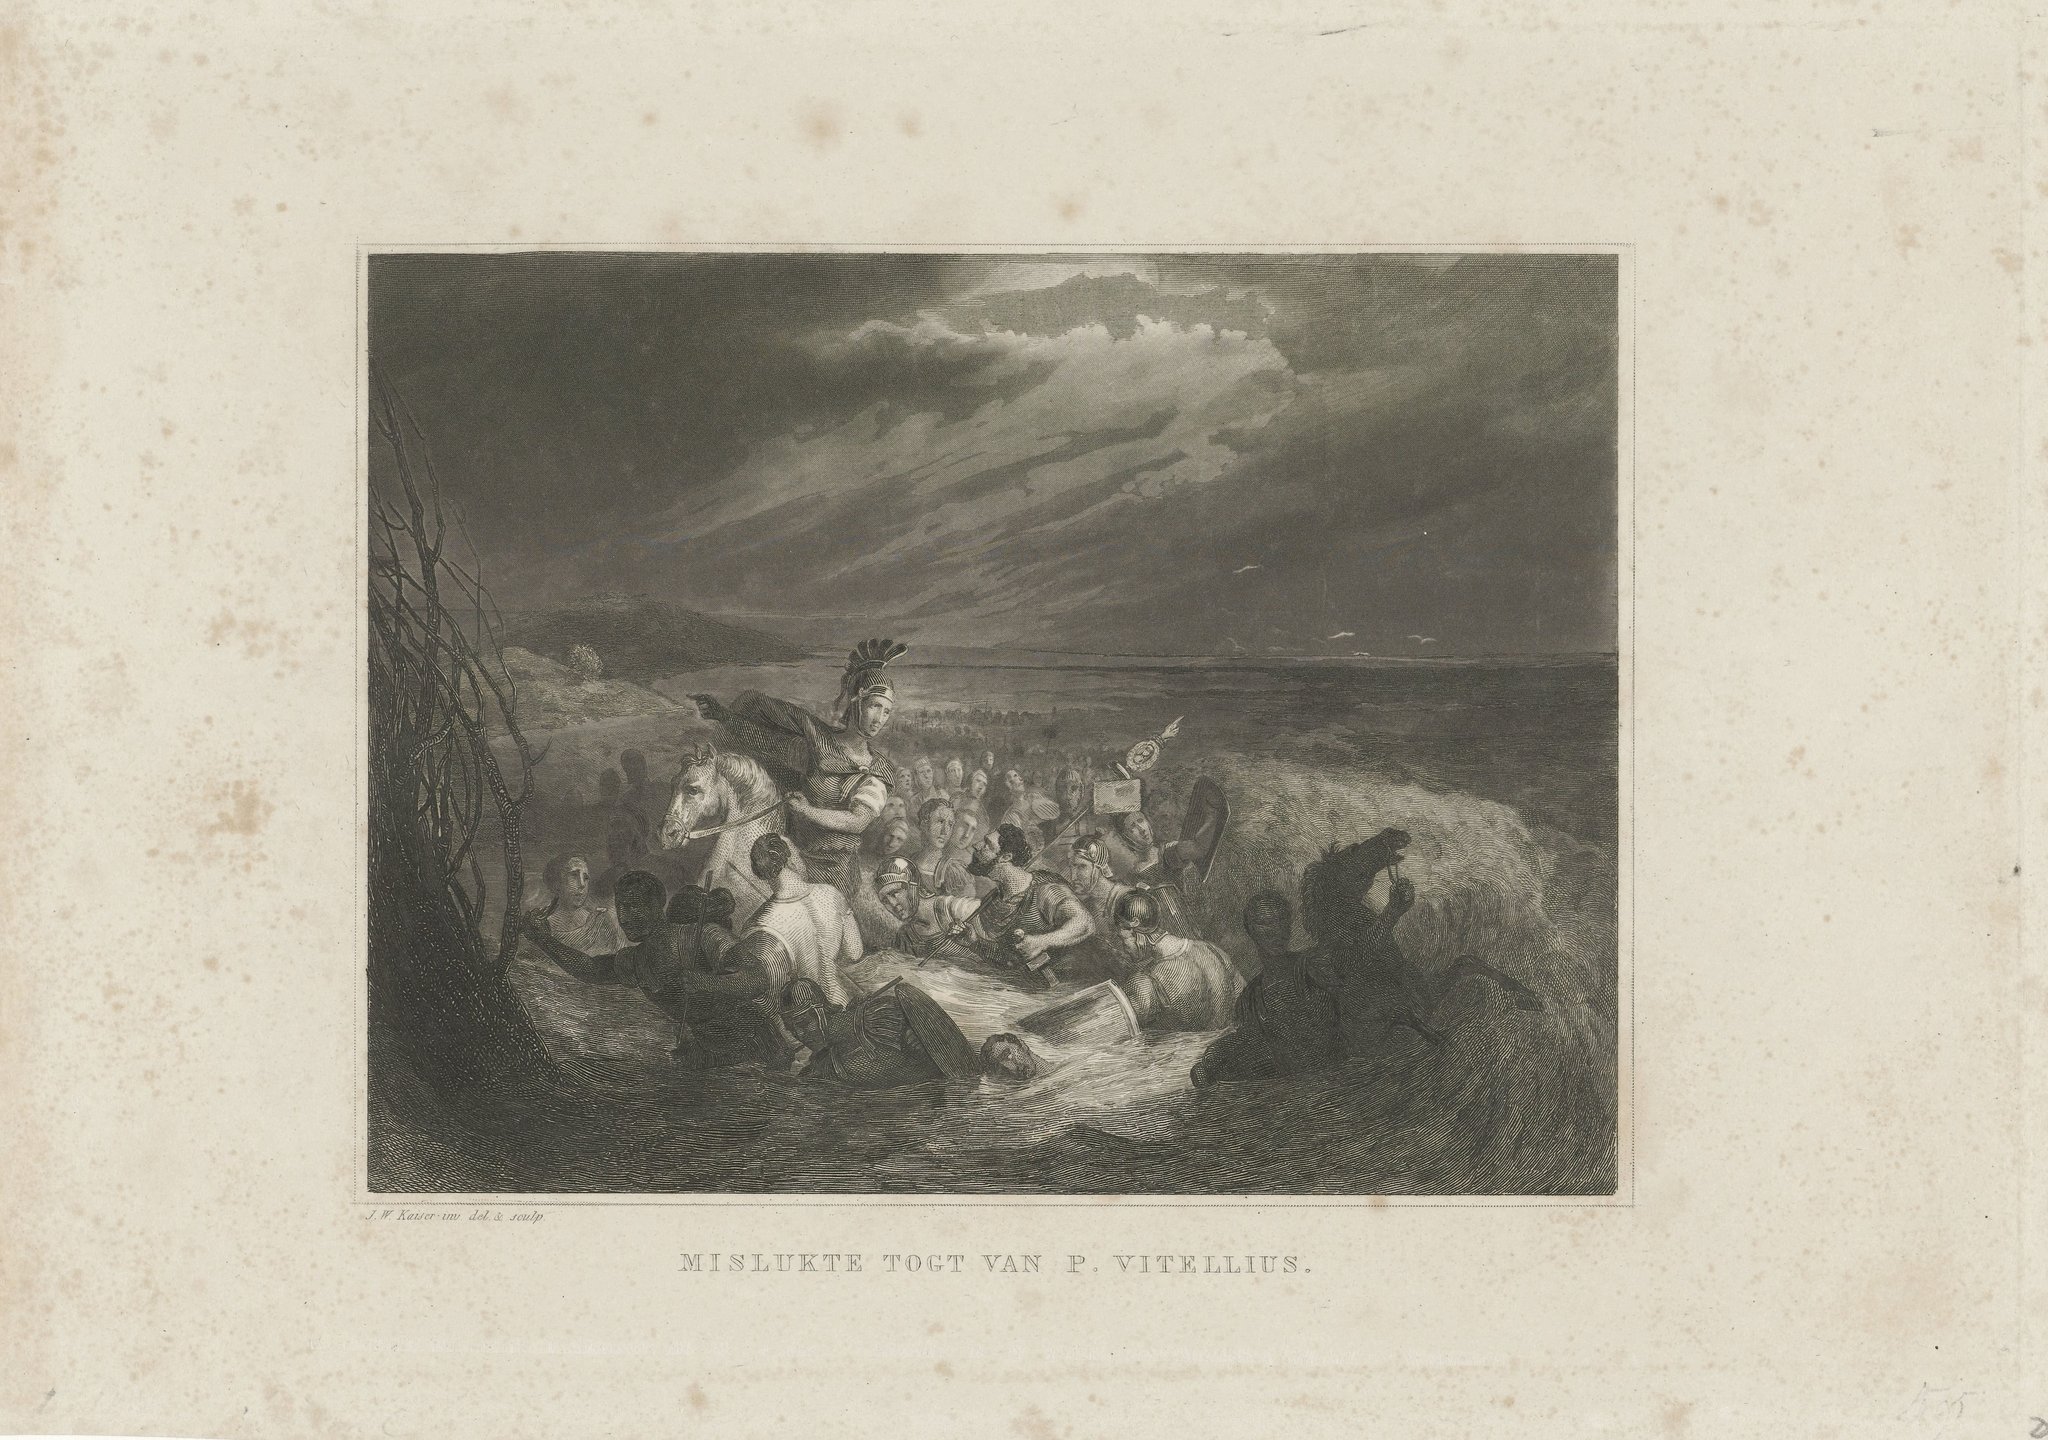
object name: print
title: Publius Vitellius door vloed overvallen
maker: johann wilhelm kaiser (i)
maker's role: draughtsman, print maker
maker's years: 1813-1900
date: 1840-1884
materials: paper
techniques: engraving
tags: flood, storm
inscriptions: collector's mark: Lugt 2228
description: De Romeinse legercommandant Publius Vitellius trekt in het jaar 17 op zijn tweede veldtocht in Germania met zijn troepen langs het strand en wordt door storm en vloed overvallen. Vitellius wijst vanaf zijn witte paard de weg naar het droge. Toch kwamen uiteindelijk veel van zijn soldaten om het leven.